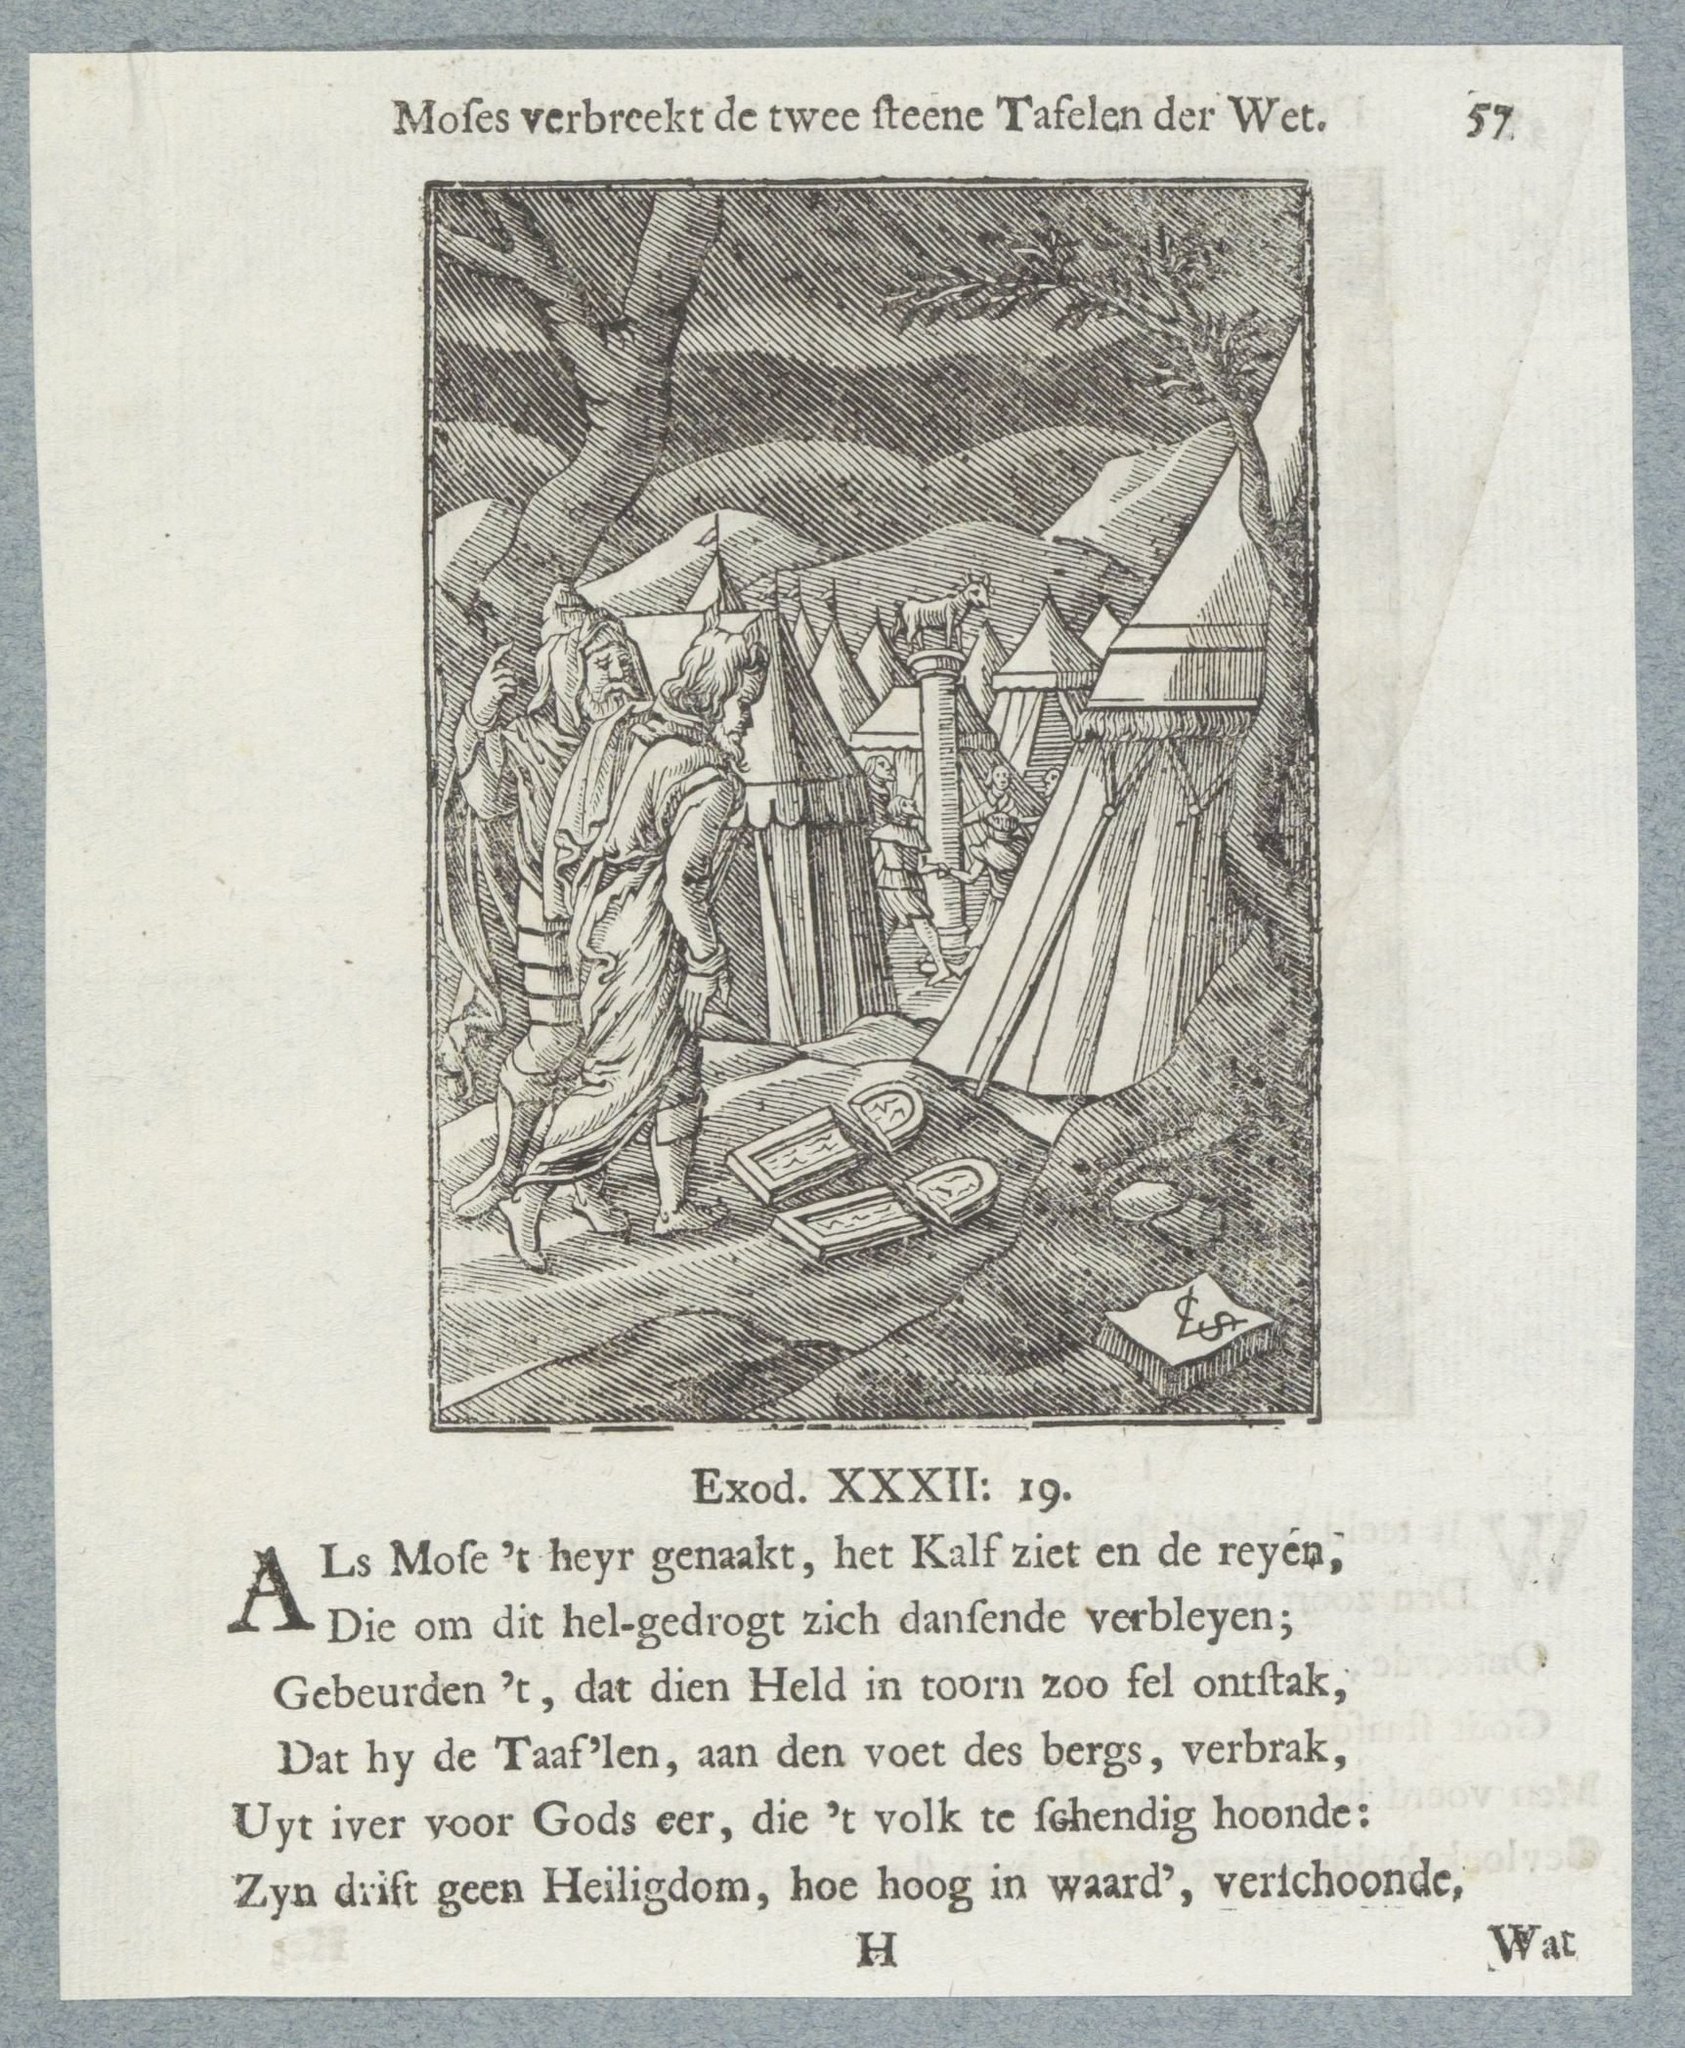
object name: album leaf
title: Mozes breekt de tafelen der wet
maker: jan klooster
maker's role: bookseller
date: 1645-1646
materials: paper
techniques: letterpress printing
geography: amsterdam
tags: on seeing the idolaters moses breaks the tables of the law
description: De prent is afkomstig uit: Bybels Lusthof. Amsterdam, J. Klooster, 1740. De prent werd gemaakt voor de uitgaven van P.J. Paets uit Amsterdam. Ze komt in ieder geval voor in: Bibels Tresoor ofte der zielen lusthof. Amsterdam, P.J. Paets, 1646. Mogelijk staat ze ook in: Historien ende Prophetien. [Amsterdam], P.J. Paets, 1645.